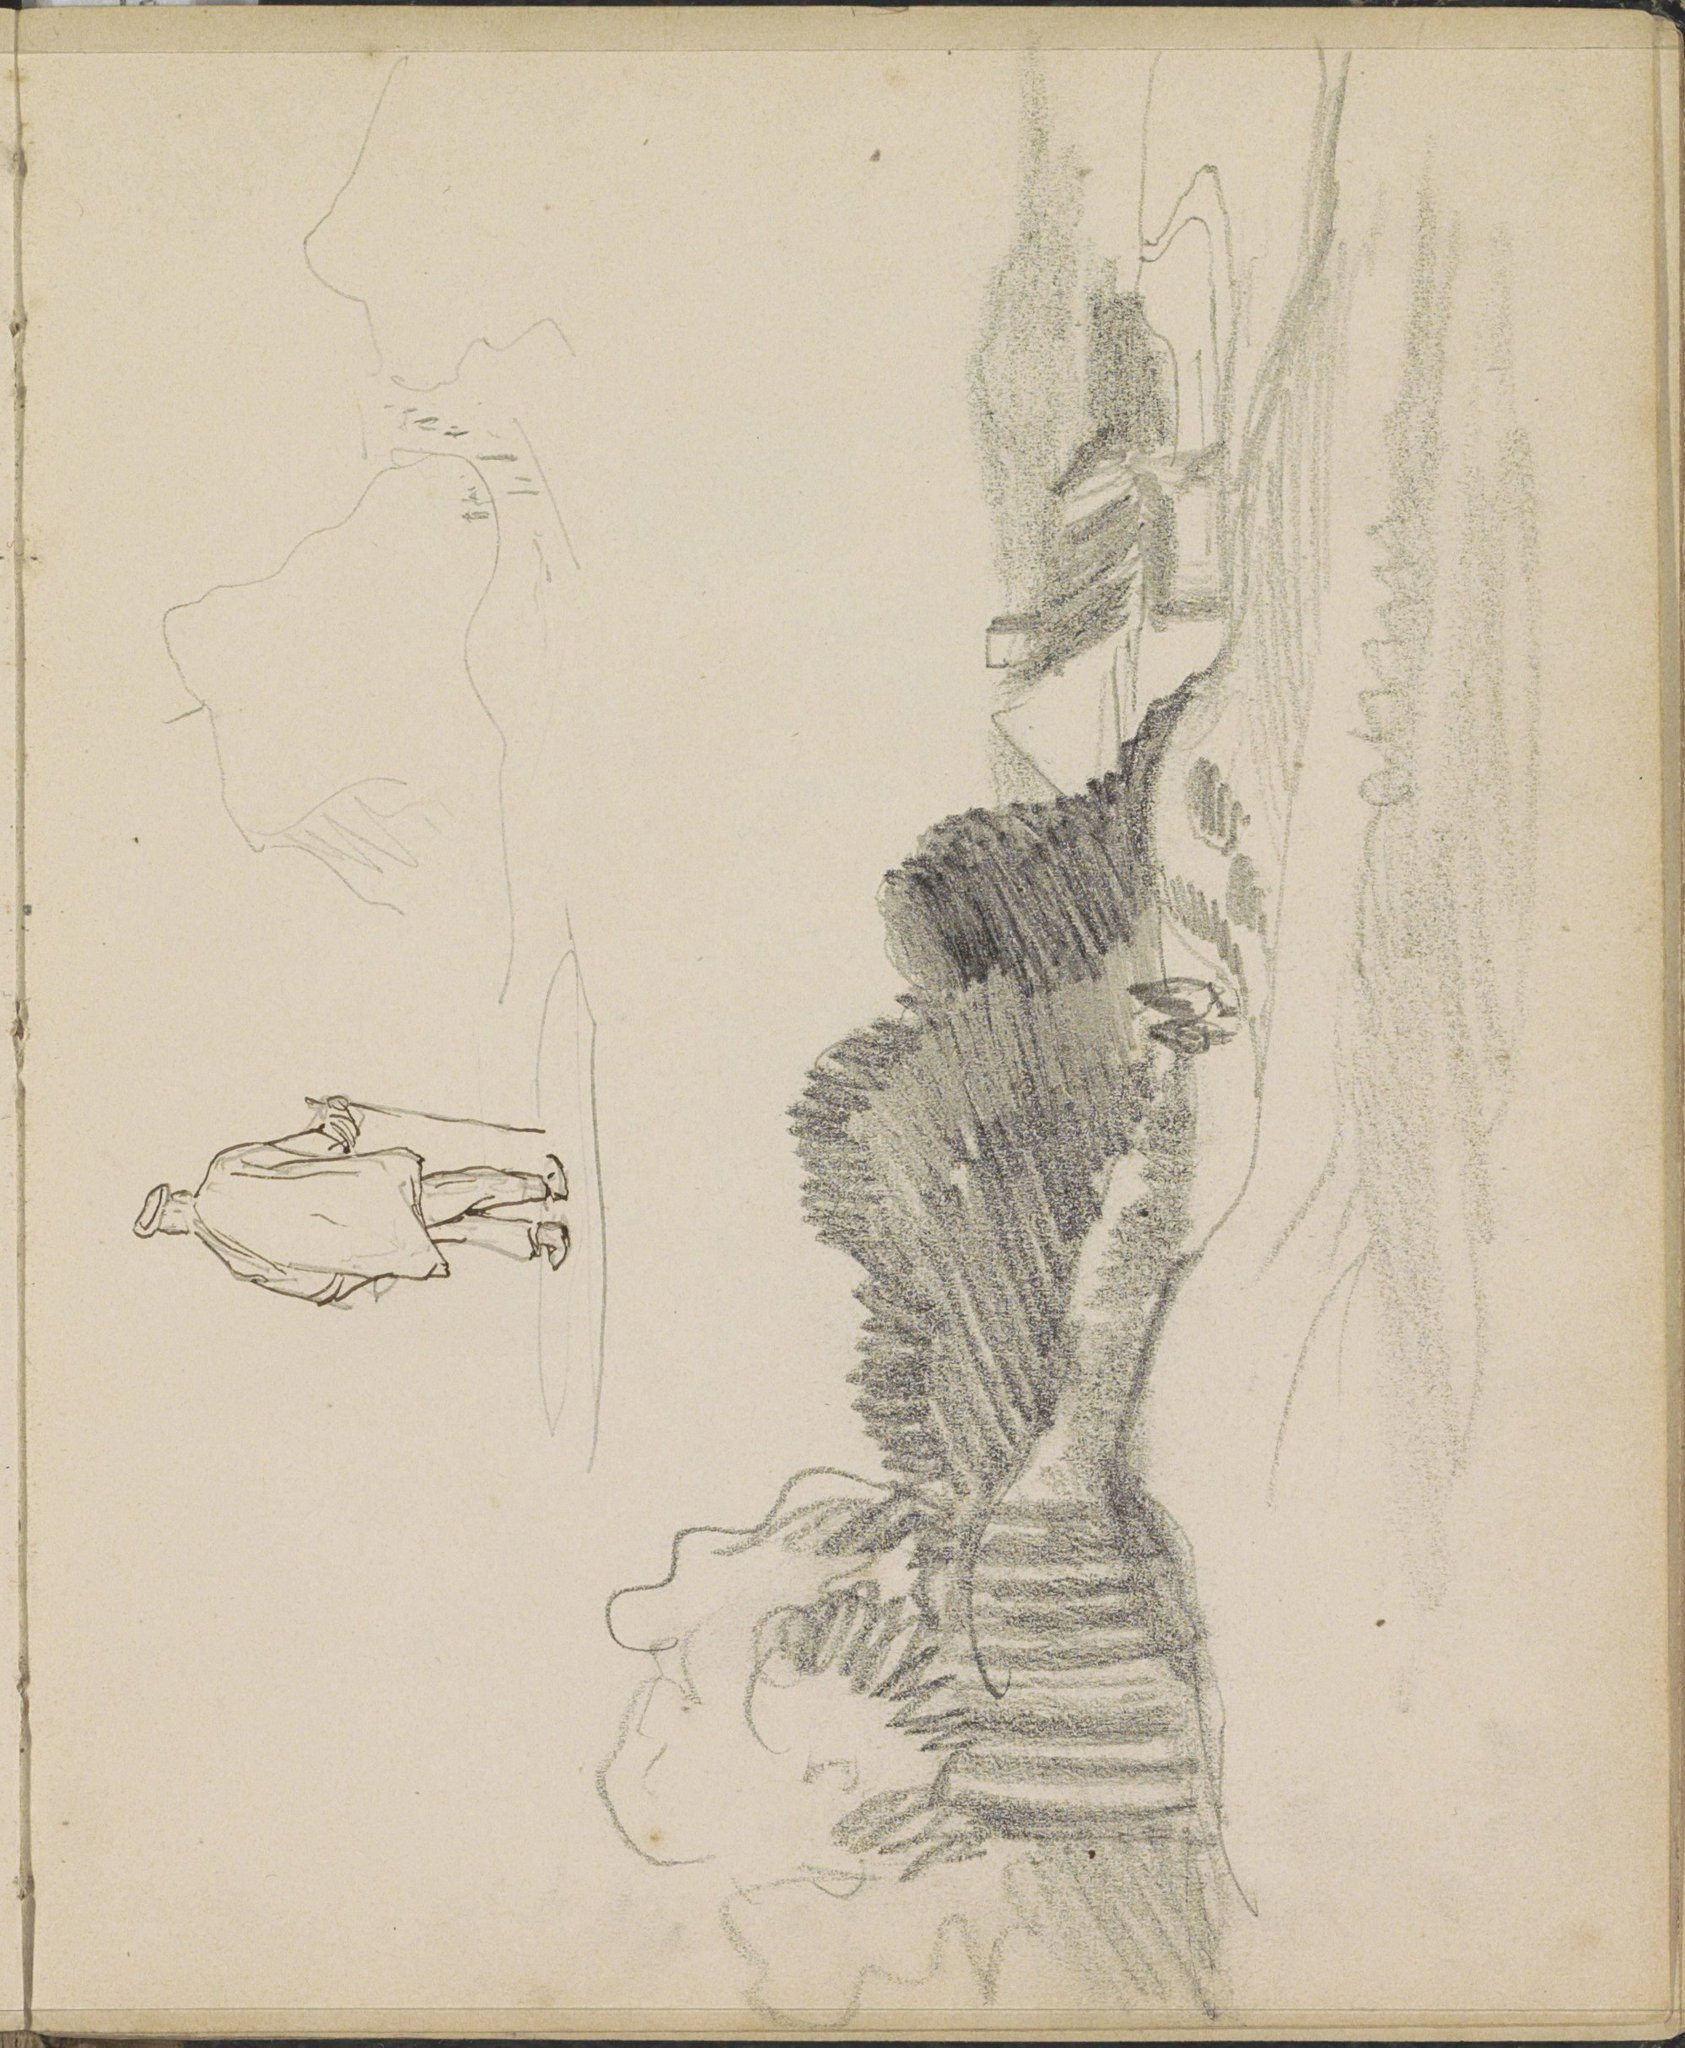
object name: sketchbook leaf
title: Figuren in een heuvellandschap en een man met een wandelstok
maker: johannes tavenraat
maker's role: draughtsman, painter, print maker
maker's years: 1809-1881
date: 1841-1853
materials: ink, paper, pencil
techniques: pen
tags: city-view, and landscape with man-made constructions, walking-stick, staff, adult man, rural housing, e.g. country-house, villa, cottage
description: Blad 31 recto uit een schetsboek met 87 bladen.